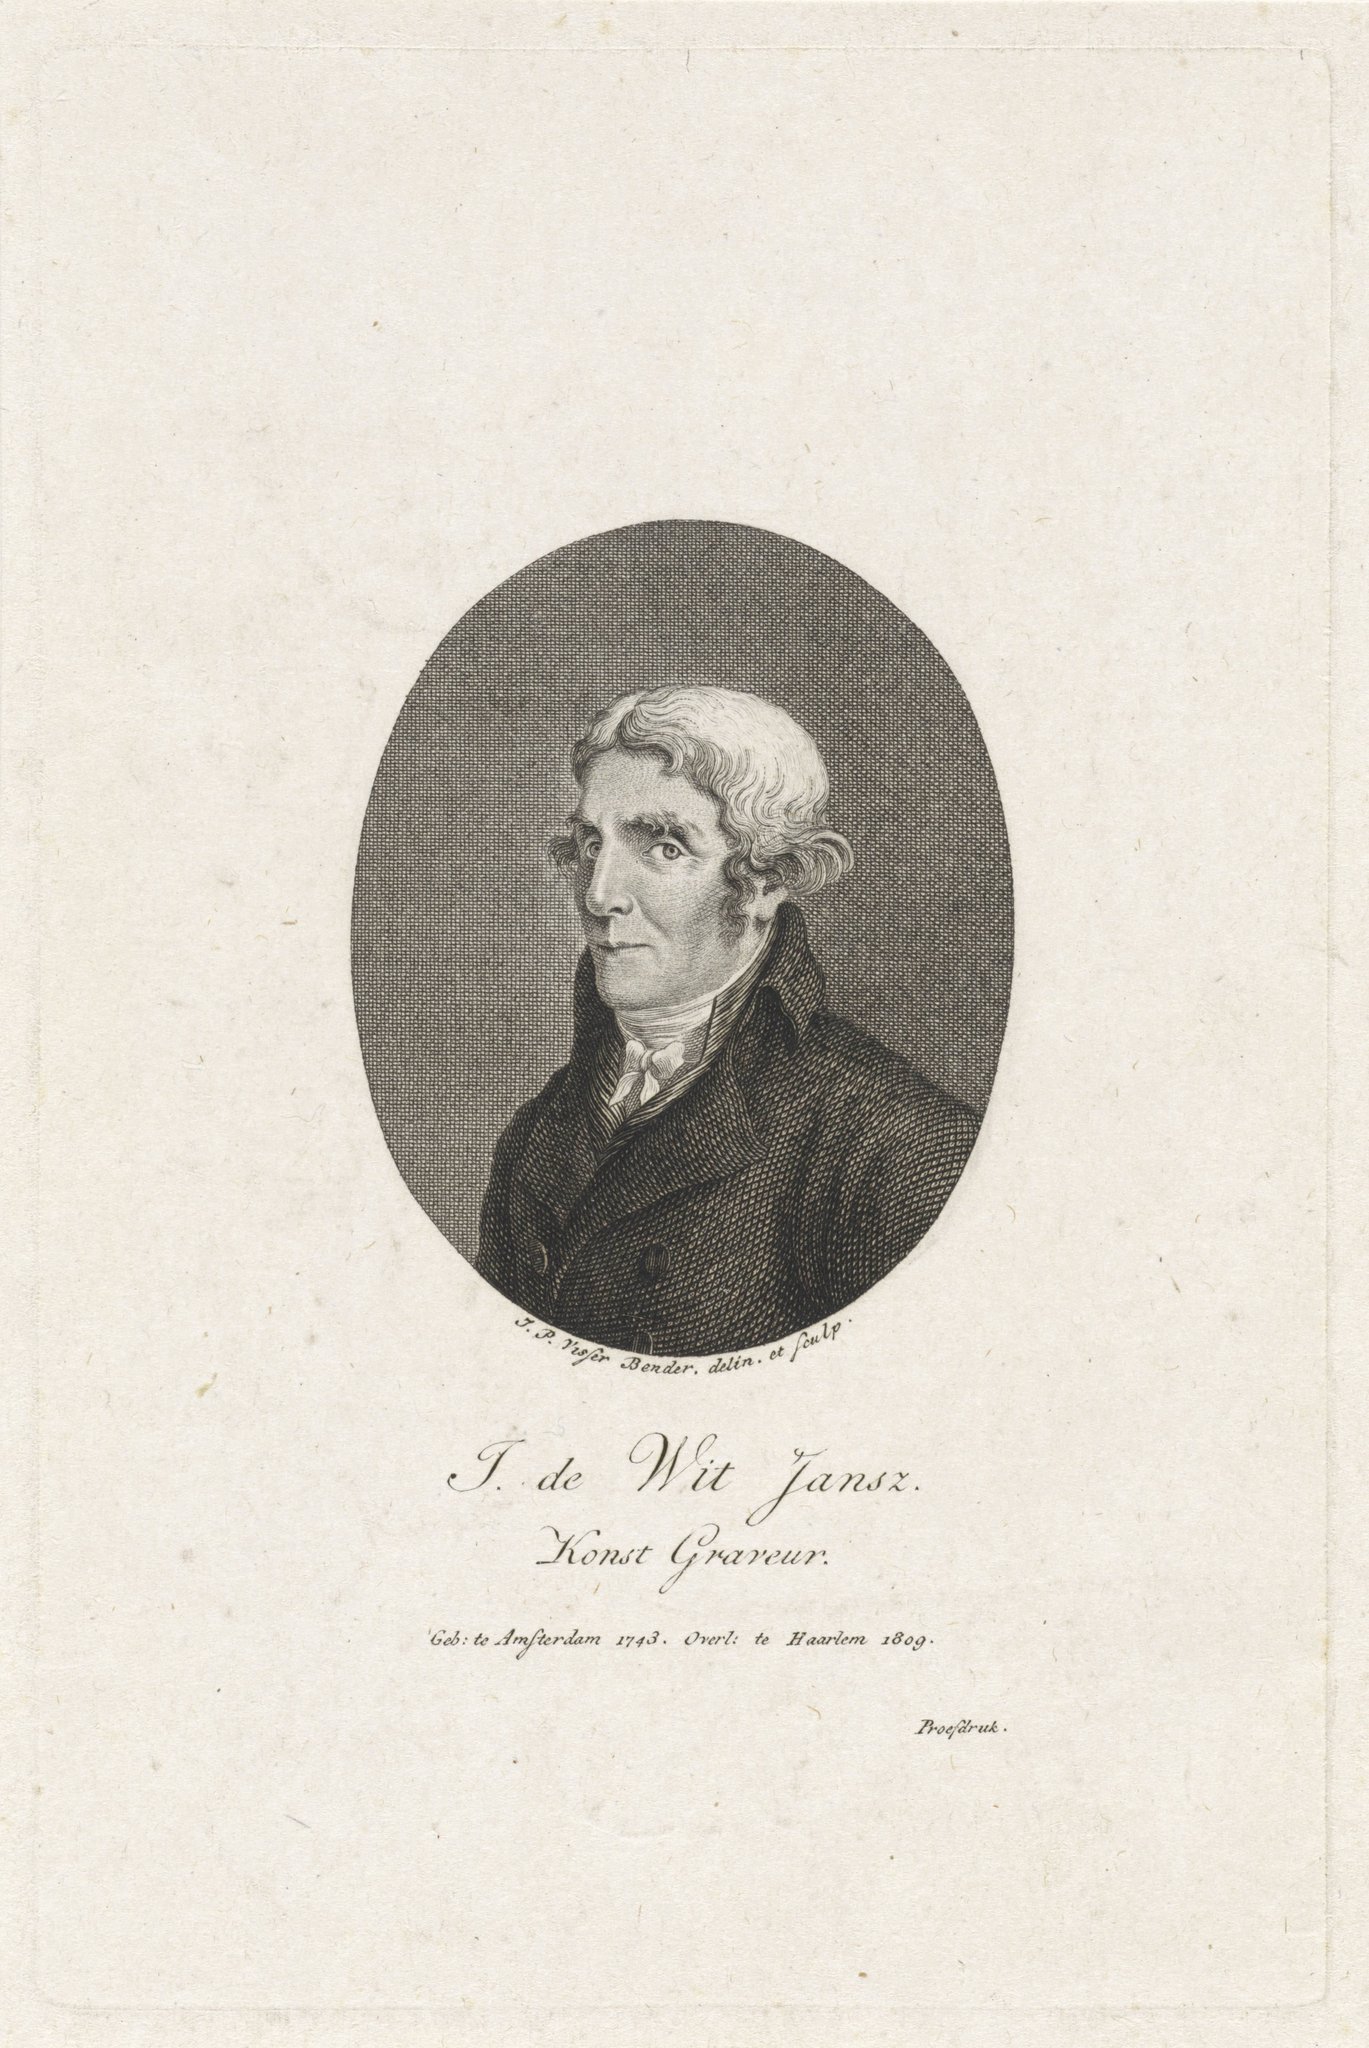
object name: print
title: Portret van Izaak Jansz. de Wit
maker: joannes pieter visser bender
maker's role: draughtsman, print maker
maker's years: 1785-1813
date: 1809-1813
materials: paper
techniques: engraving, etching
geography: haarlem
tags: amsterdam, print maker, draughtsman, izaak jansz. de wit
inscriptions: collector's mark: Lugt 2228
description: Portret van de Nederlandse prentmaker Izaak Jansz. de Wit.